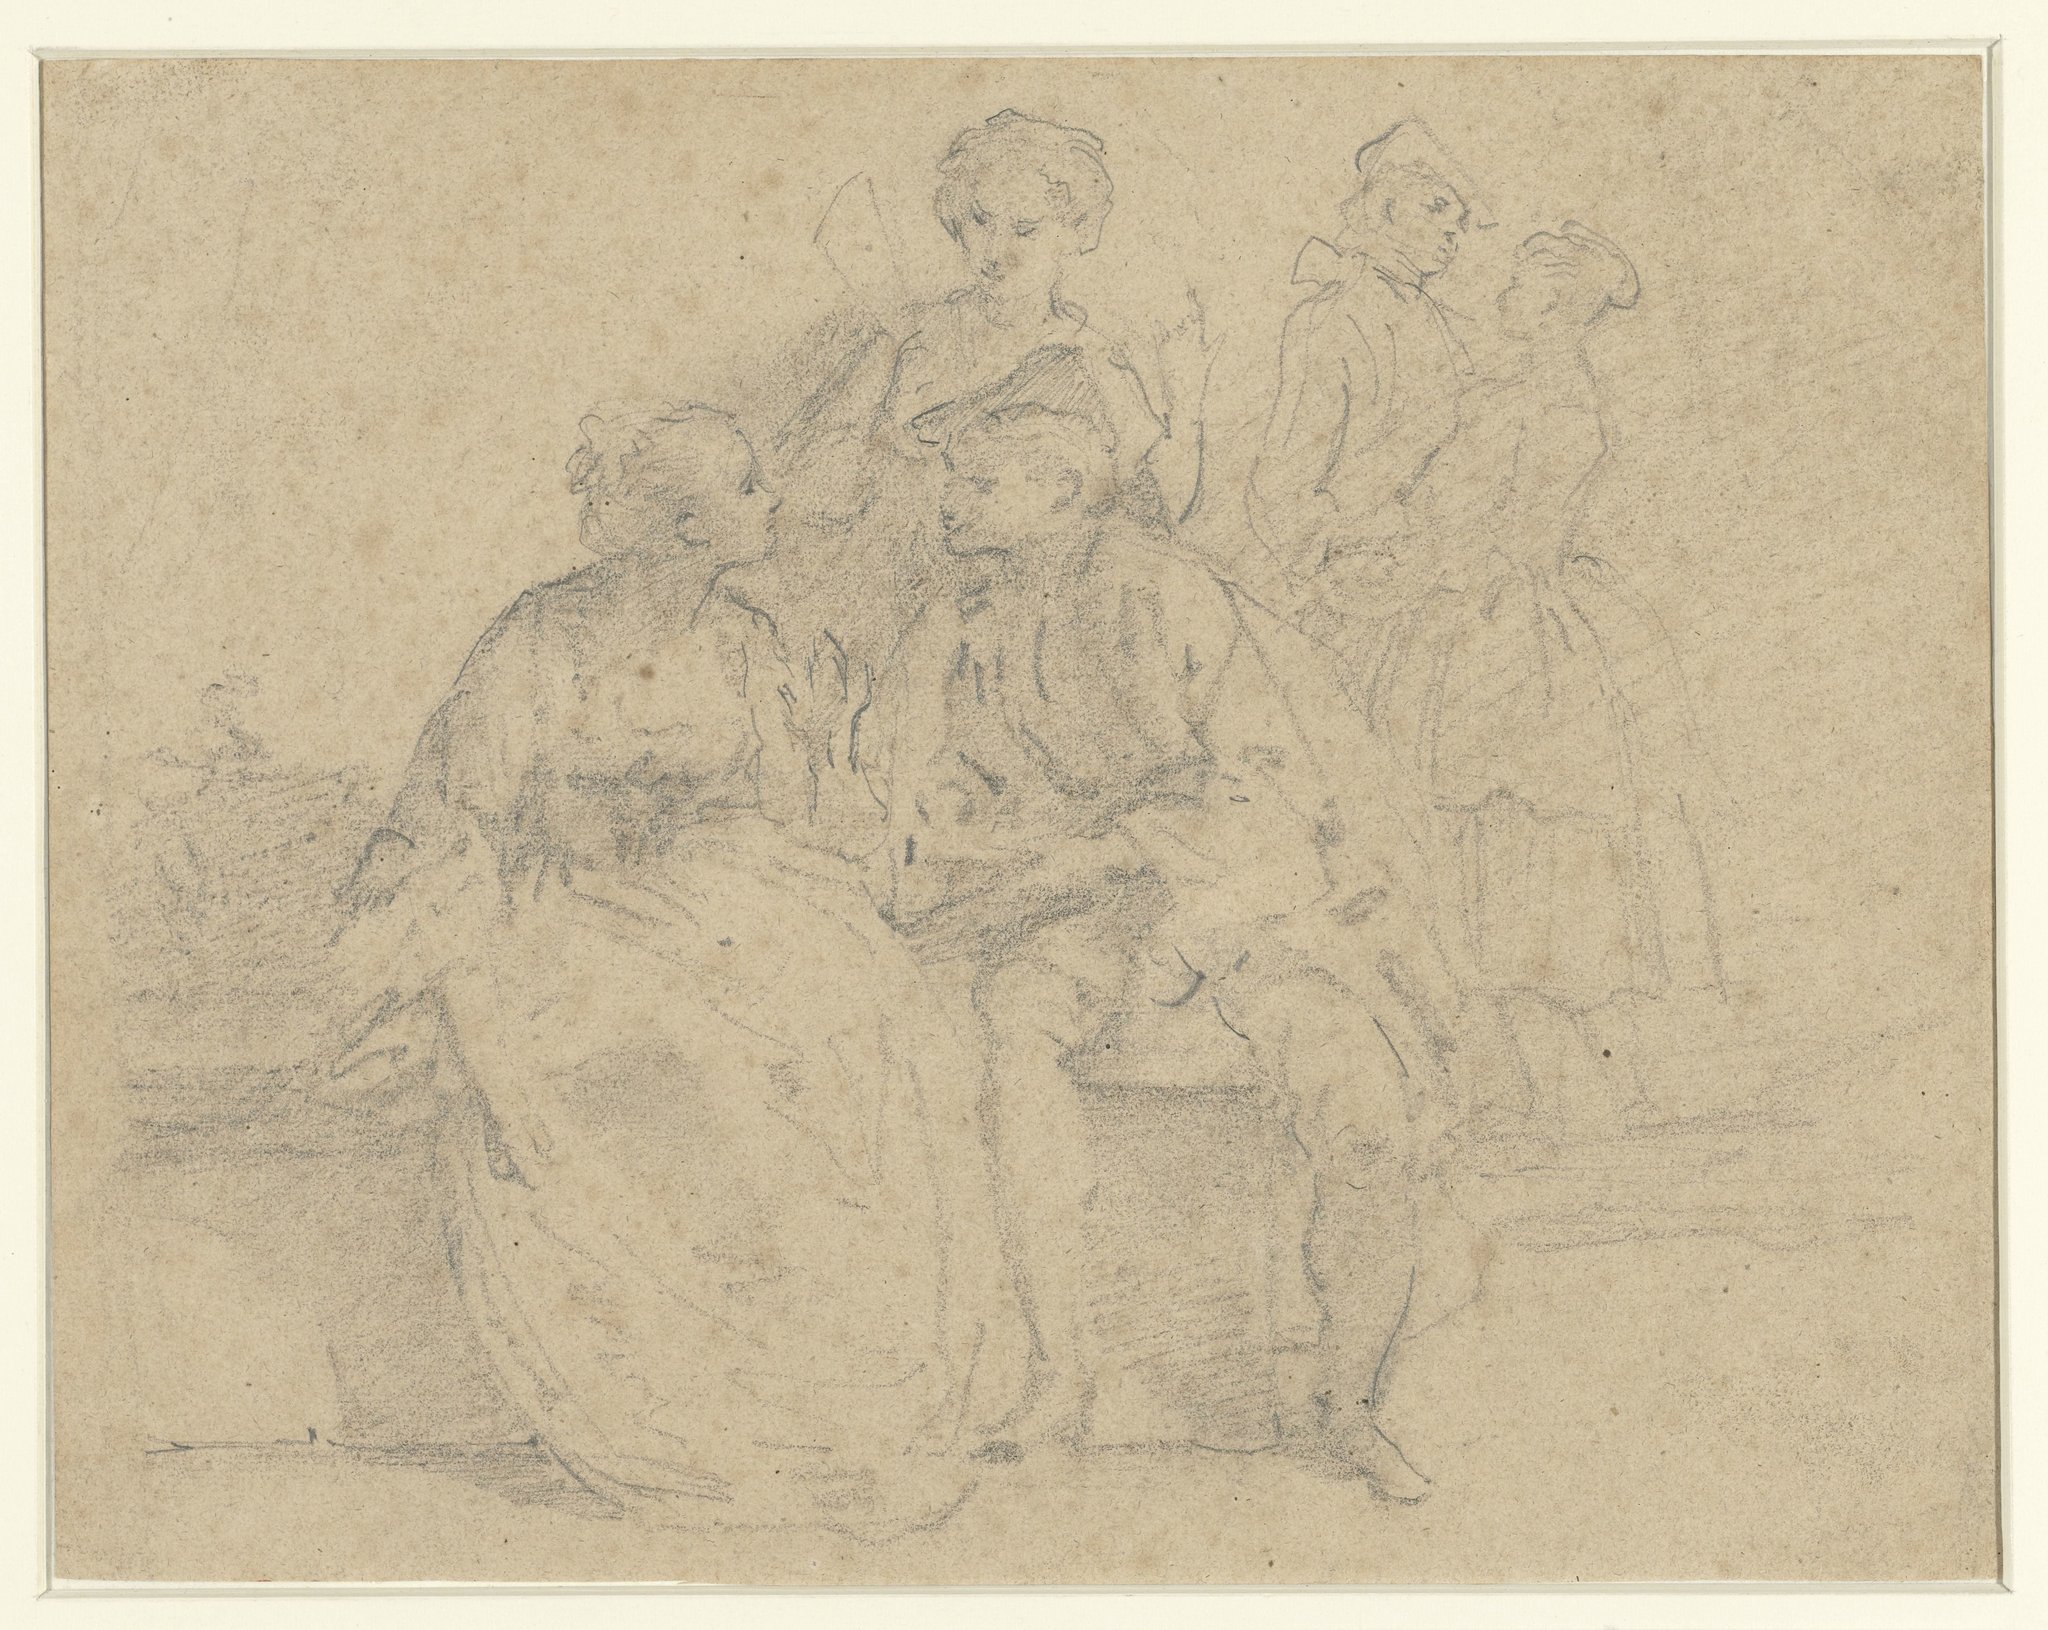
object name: drawing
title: Zittend en staand paar in conversatie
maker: Anonymous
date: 1700-1800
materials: chalk, paper, pencil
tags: speaking, couple of lovers